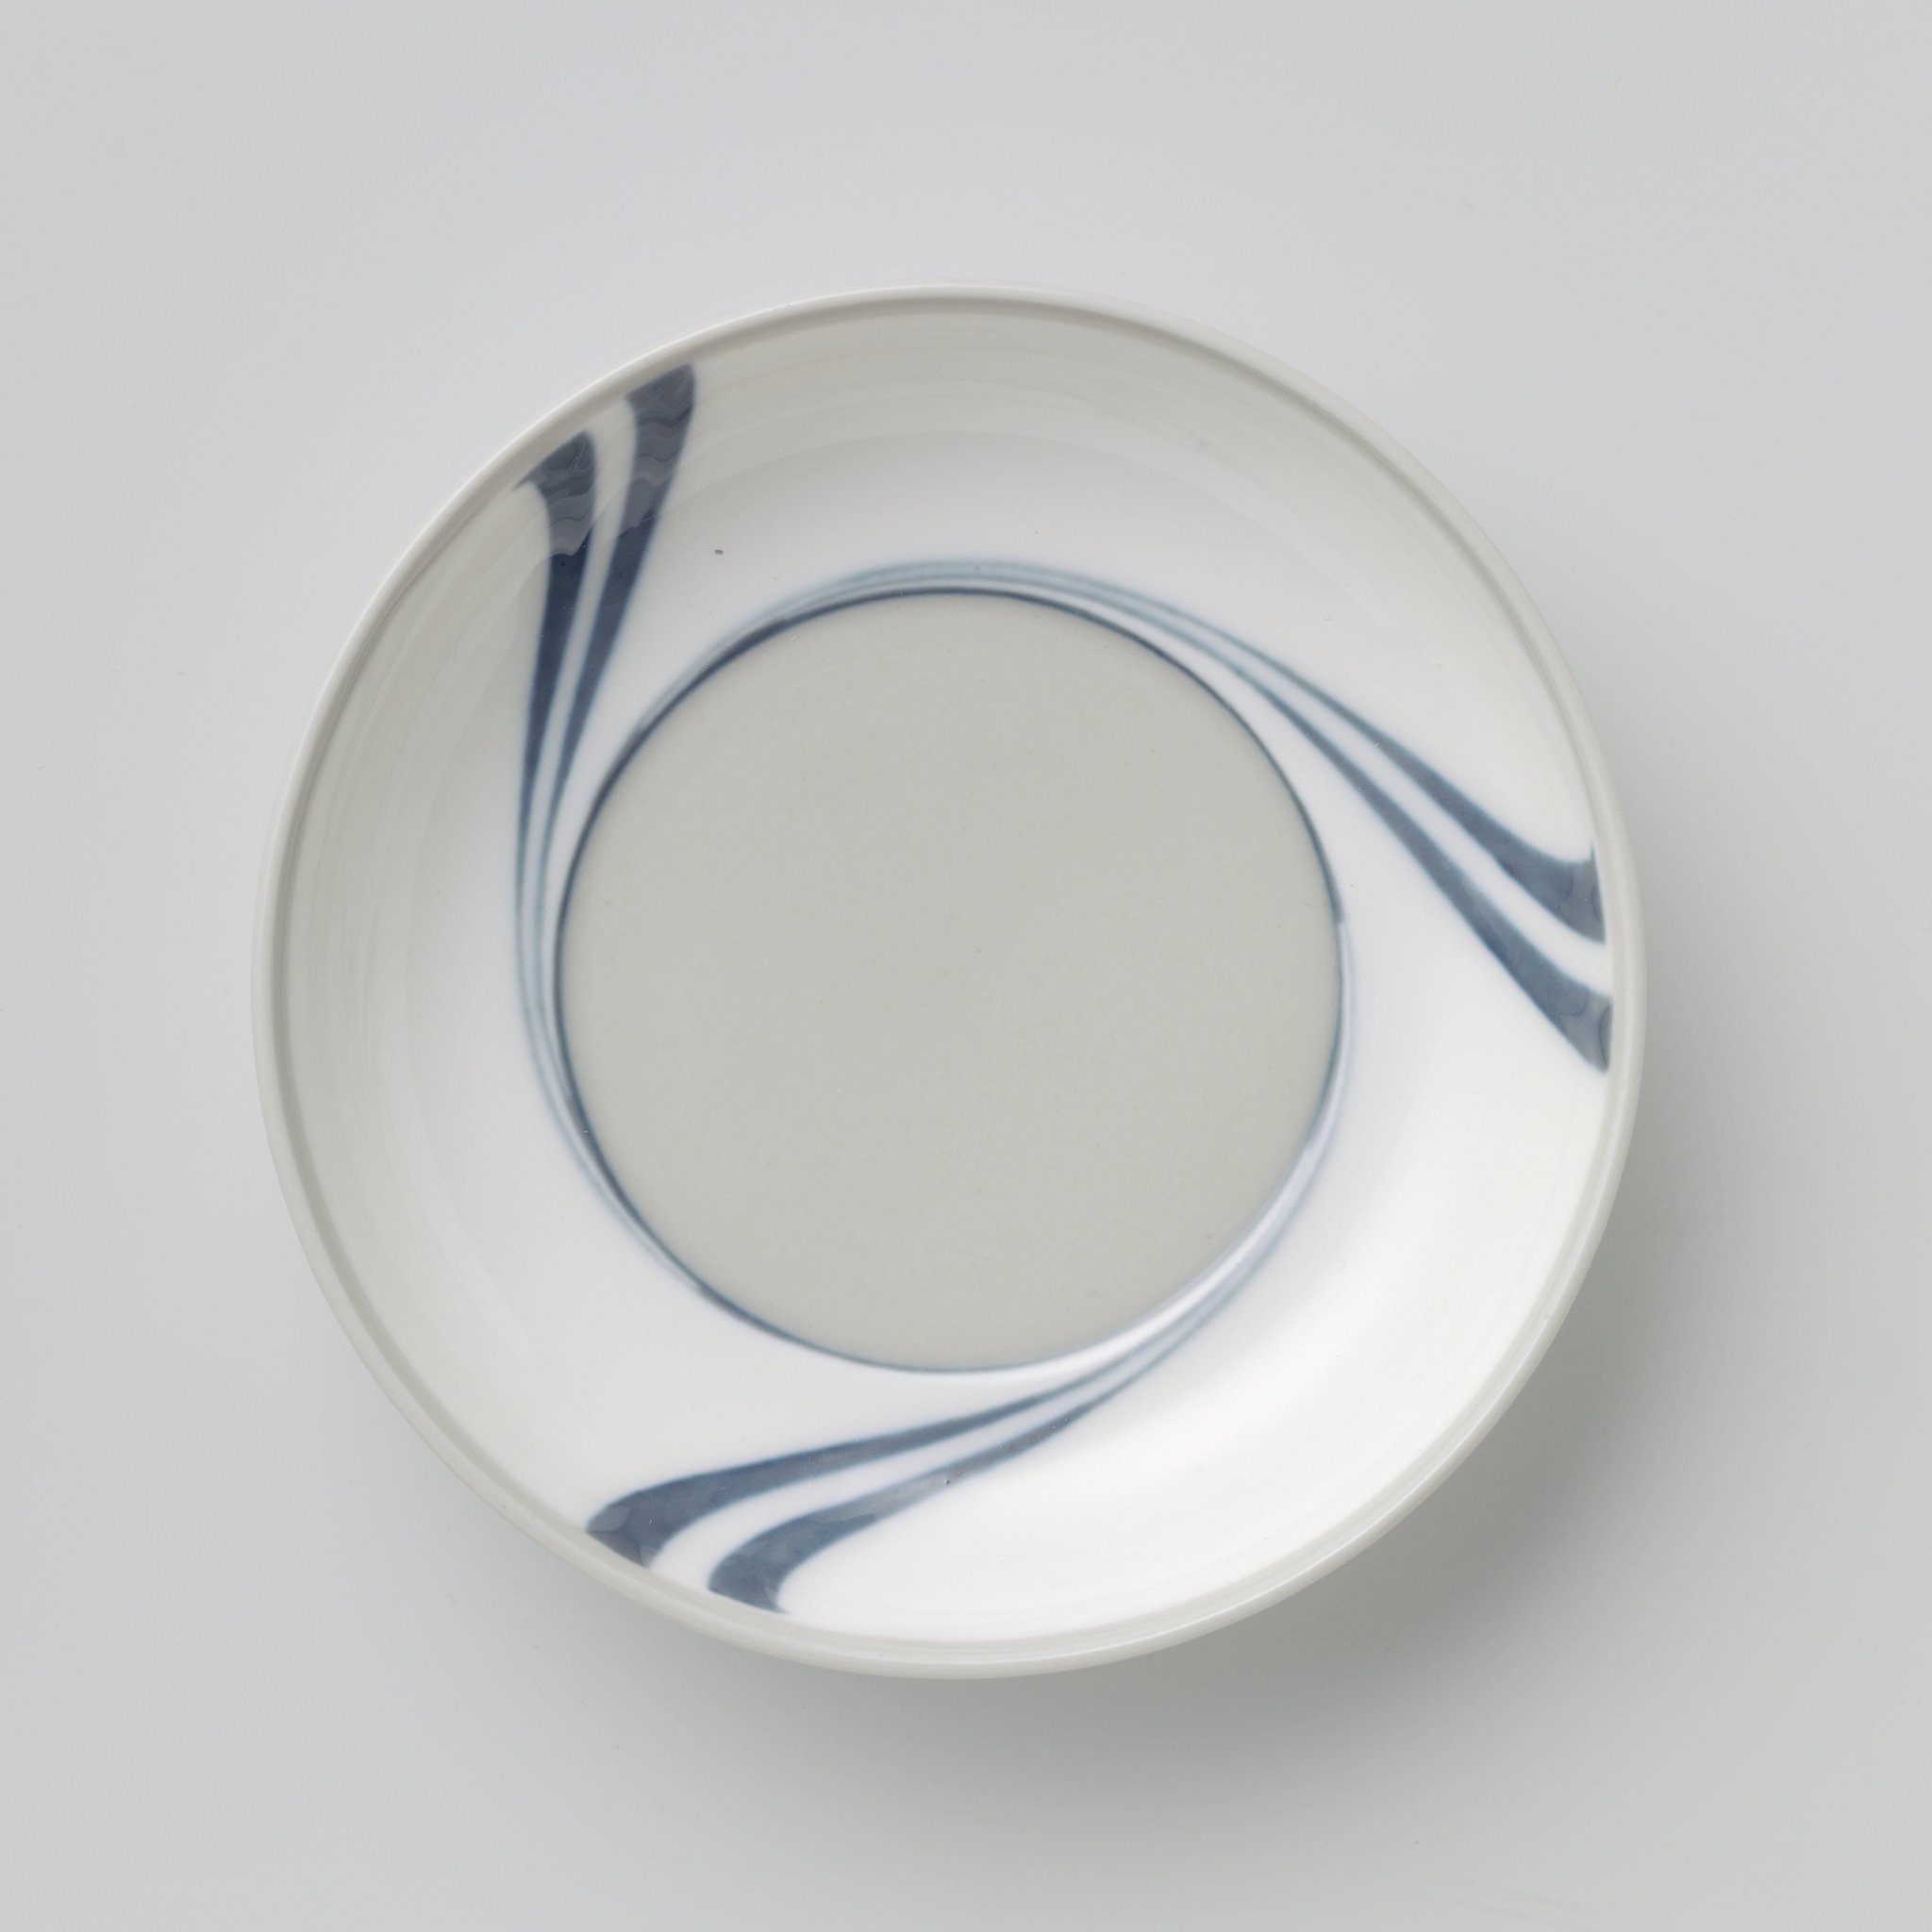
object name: platter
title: Schotel uit het koffie- en theeservies 'Saxonia'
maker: otto eduard voigt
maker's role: keramiekontwerper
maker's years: 1870-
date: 1904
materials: porcelain, chemical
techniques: painted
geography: meissen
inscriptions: model number: ‘U 127’, mark: ‘66 (of 99)’, factory mark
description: Schotel van porselein, beschilderd in blauw en grijs. De schotel hoort bij het koffie- en theeservies Saxonia. De schotel is gemerkt.